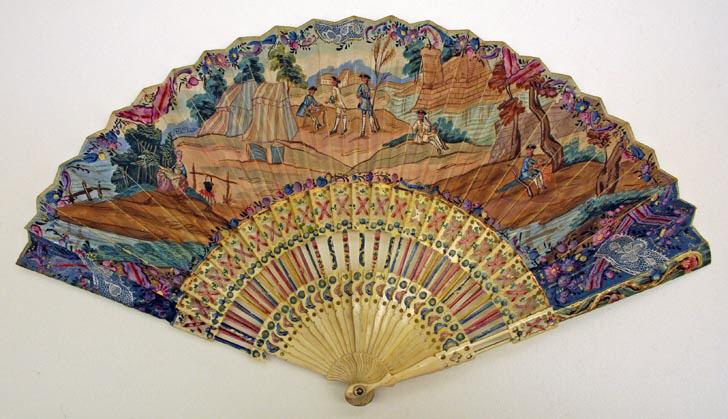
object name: fan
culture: french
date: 1701-1800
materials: ivory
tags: soldiers,camps